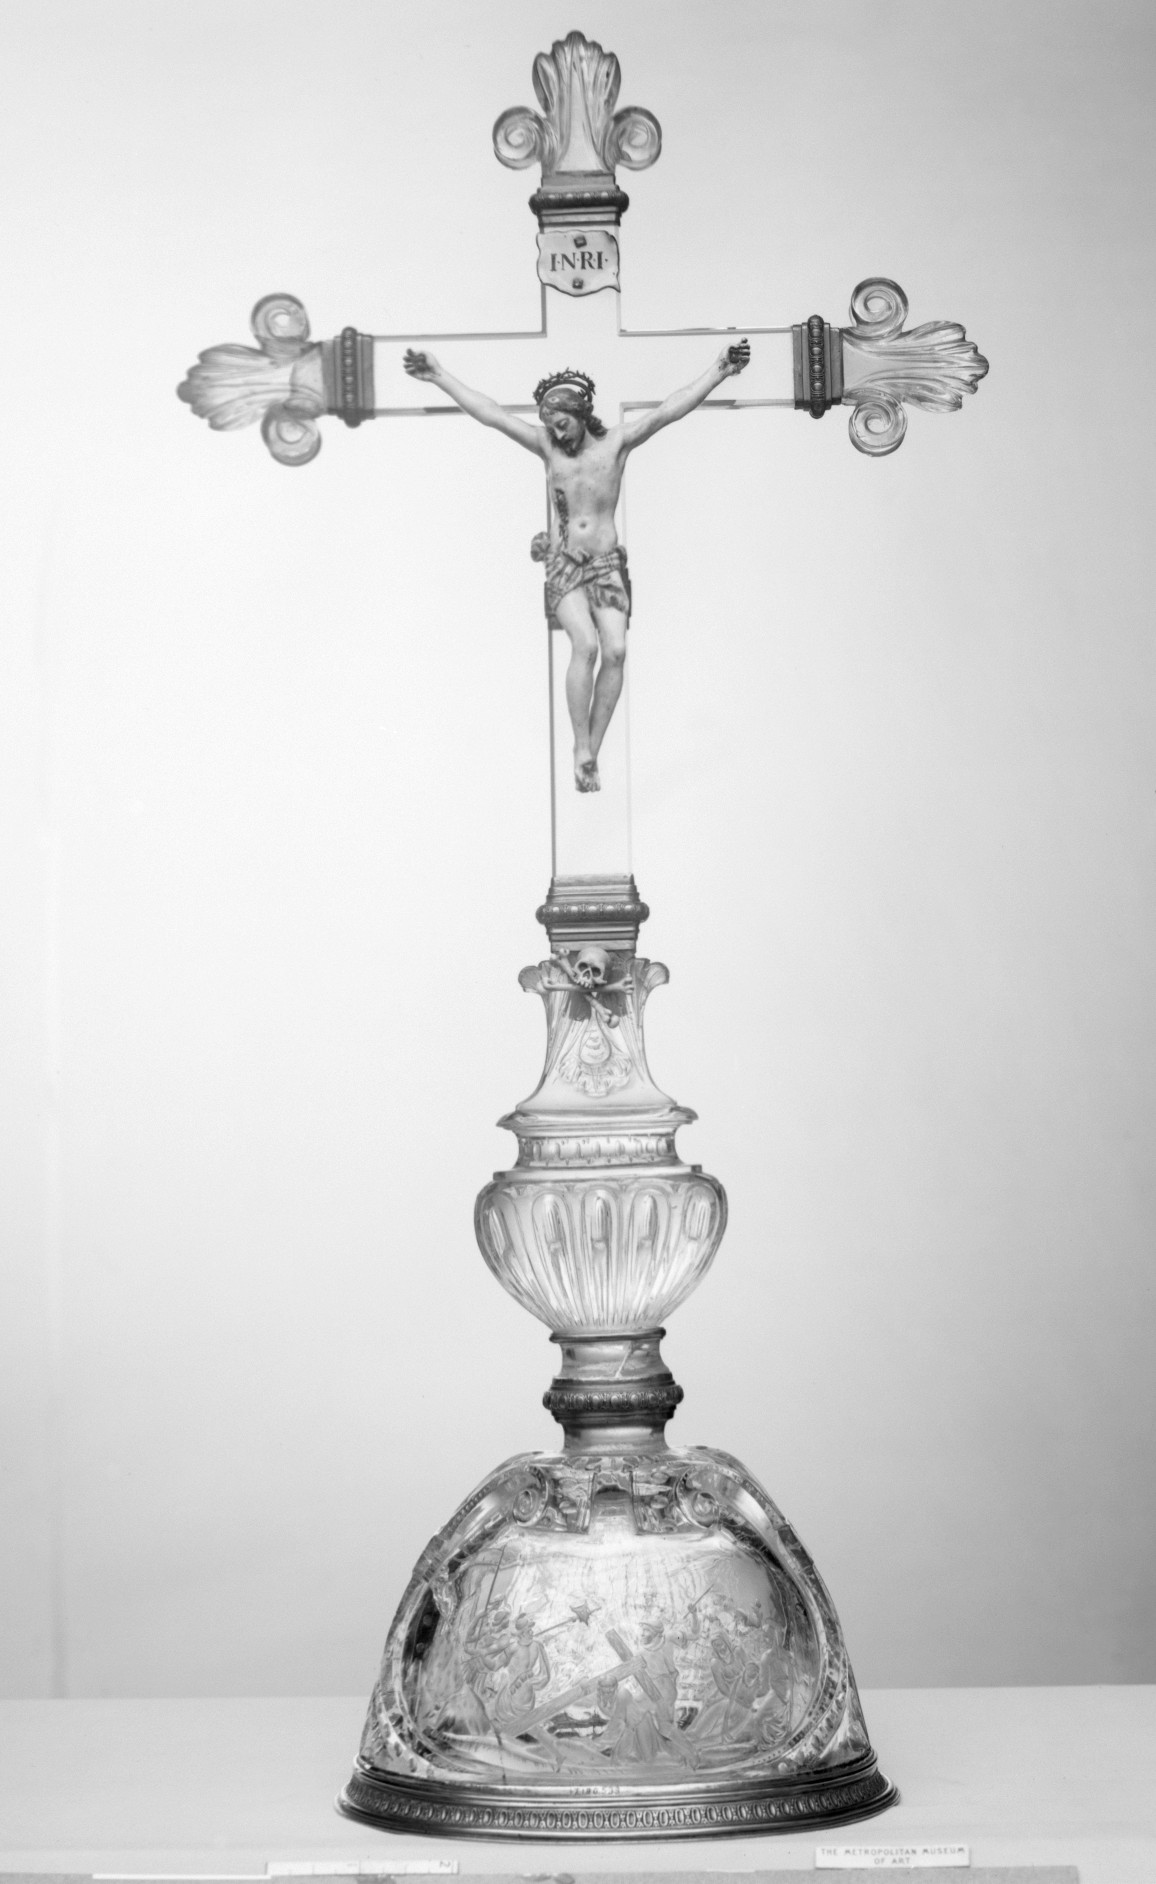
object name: crucifix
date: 1501-1600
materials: enamel, quartz, silver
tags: crucifixion